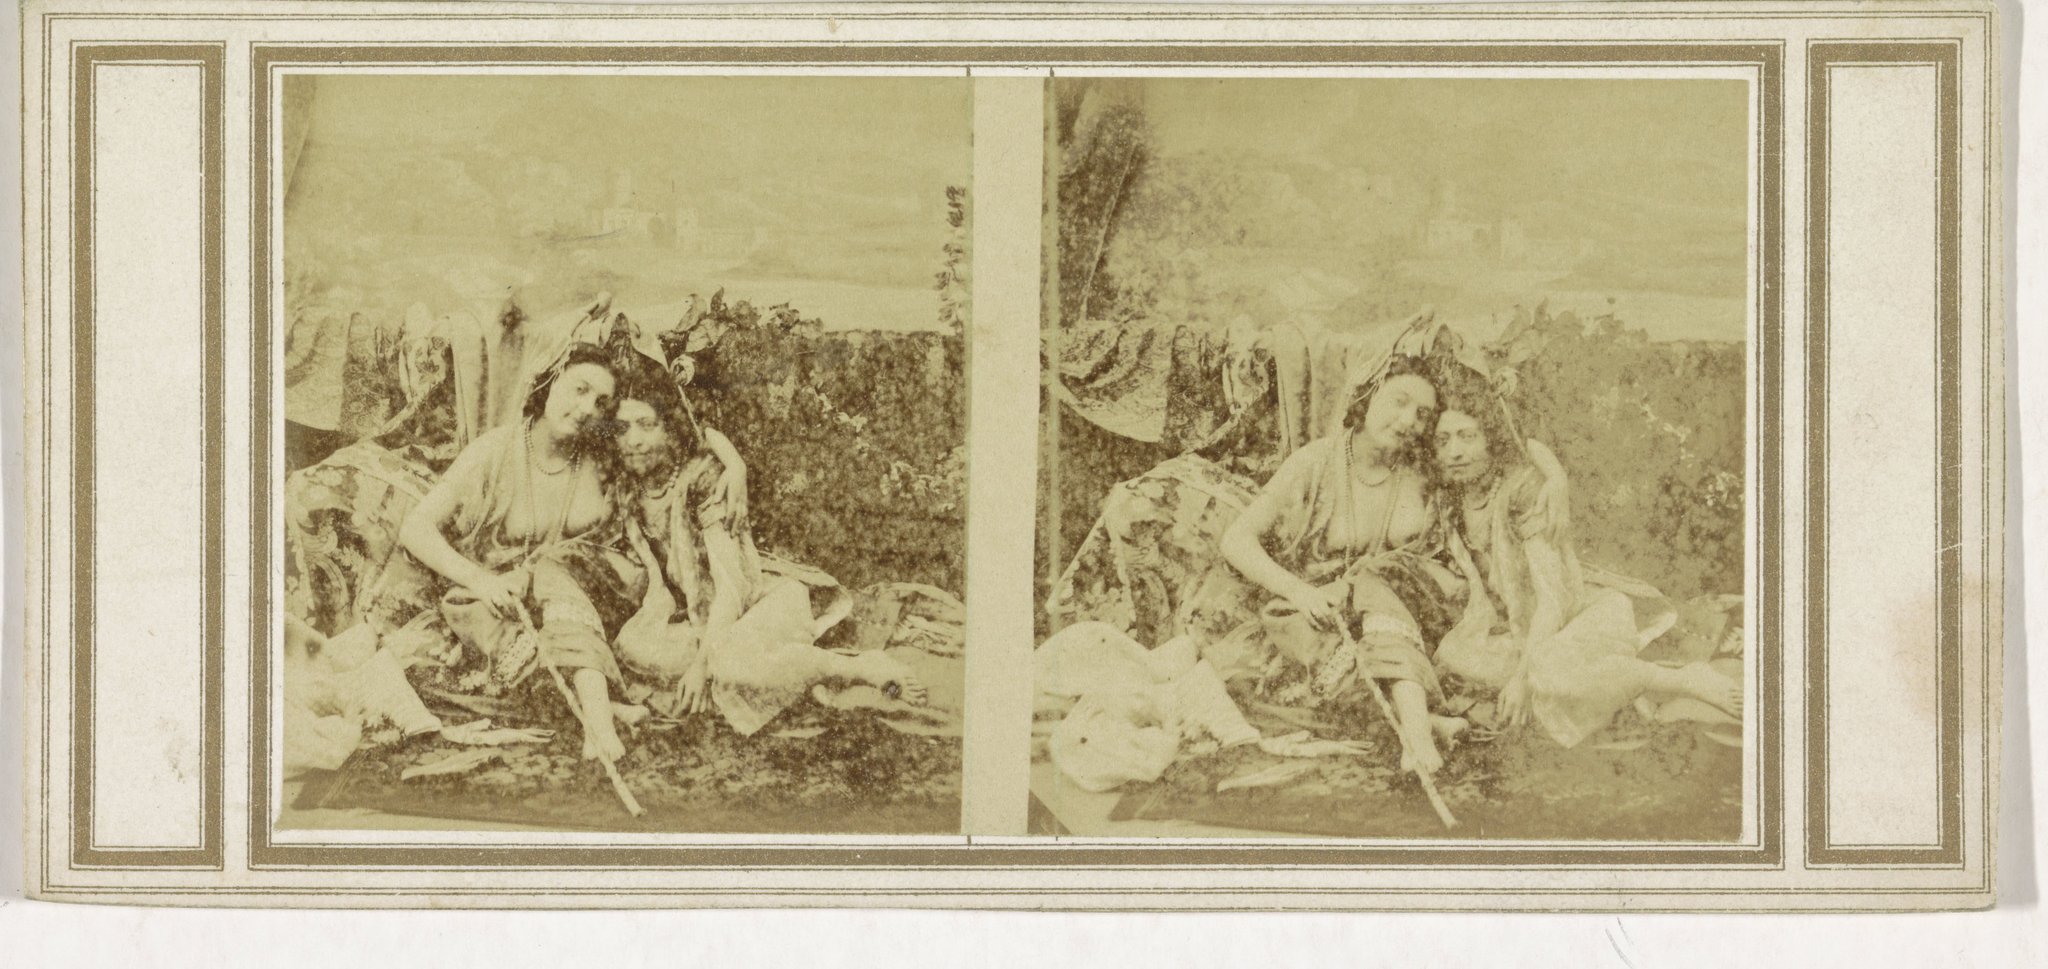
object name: stereograph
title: Twee vrouwen, waarvan de een haar arm om de schouder van de ander heeft geslagen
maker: pierre-ambroise richebourg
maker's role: fotograaf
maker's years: 1810-1875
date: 1850-1870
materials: photographic support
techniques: albumen print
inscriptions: number: ‘119’